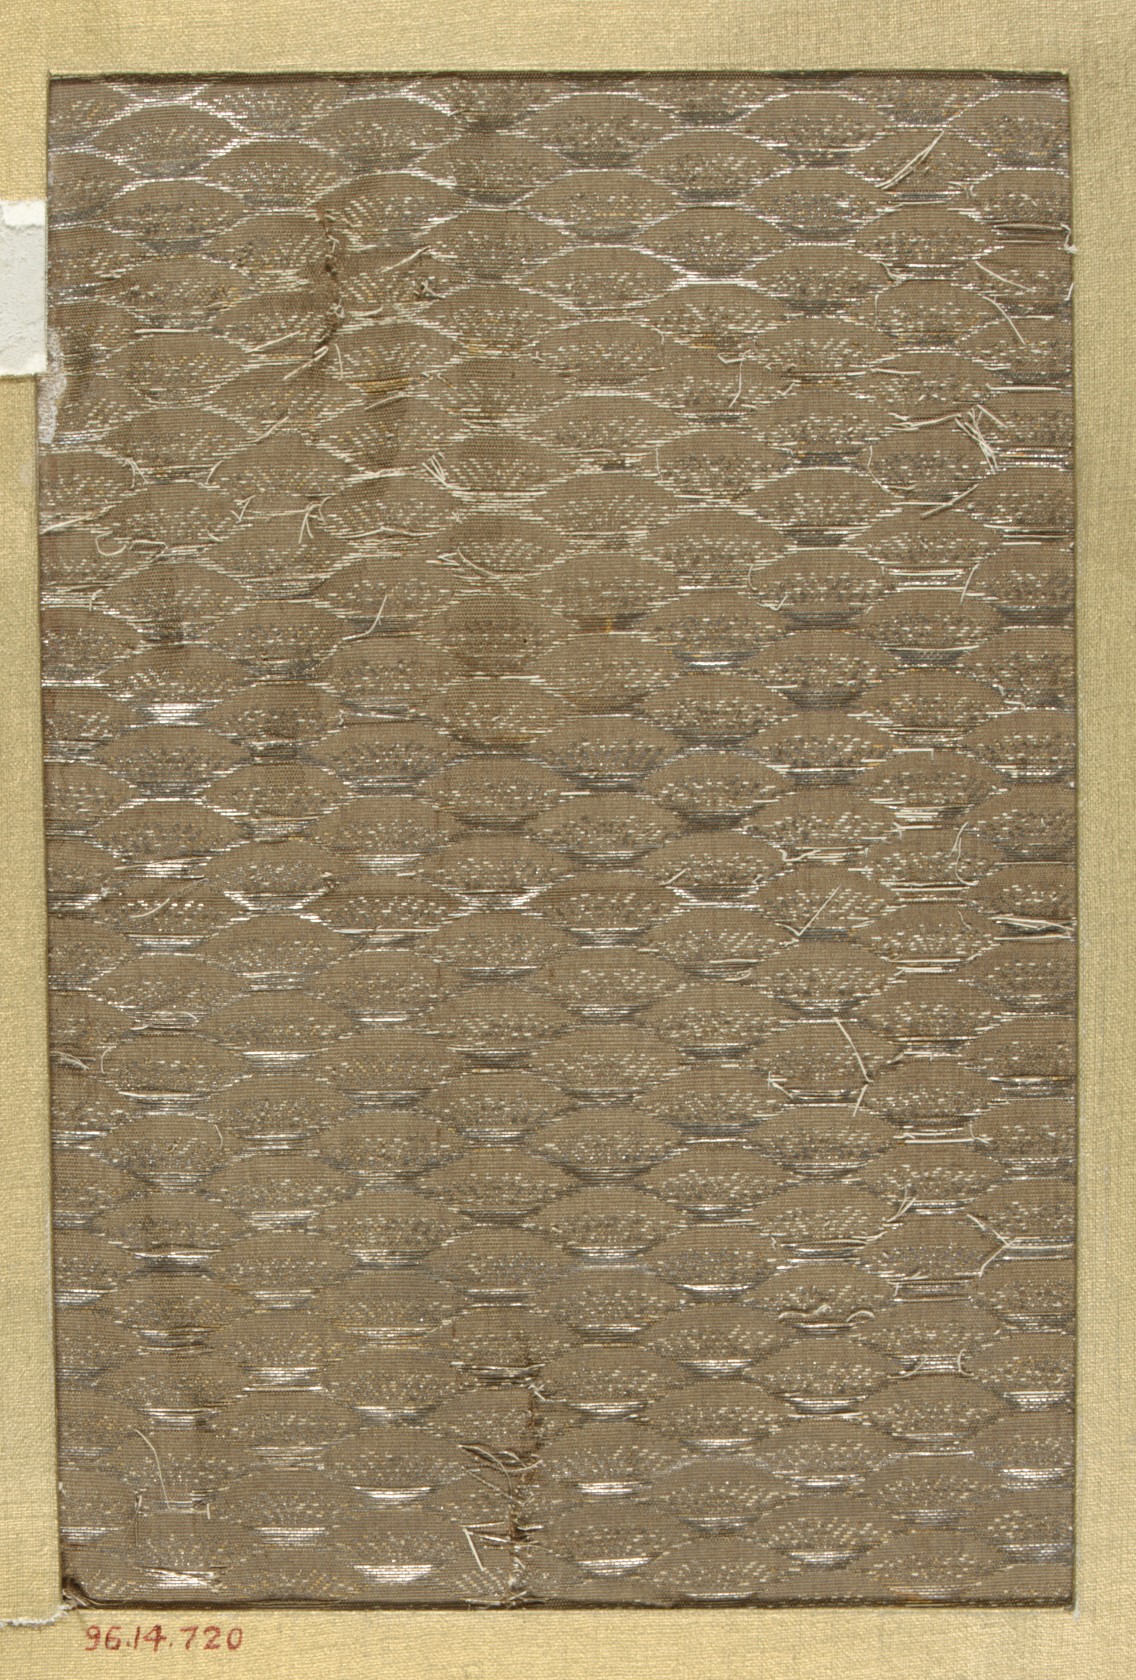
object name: piece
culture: japanese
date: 1701-1900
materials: silk